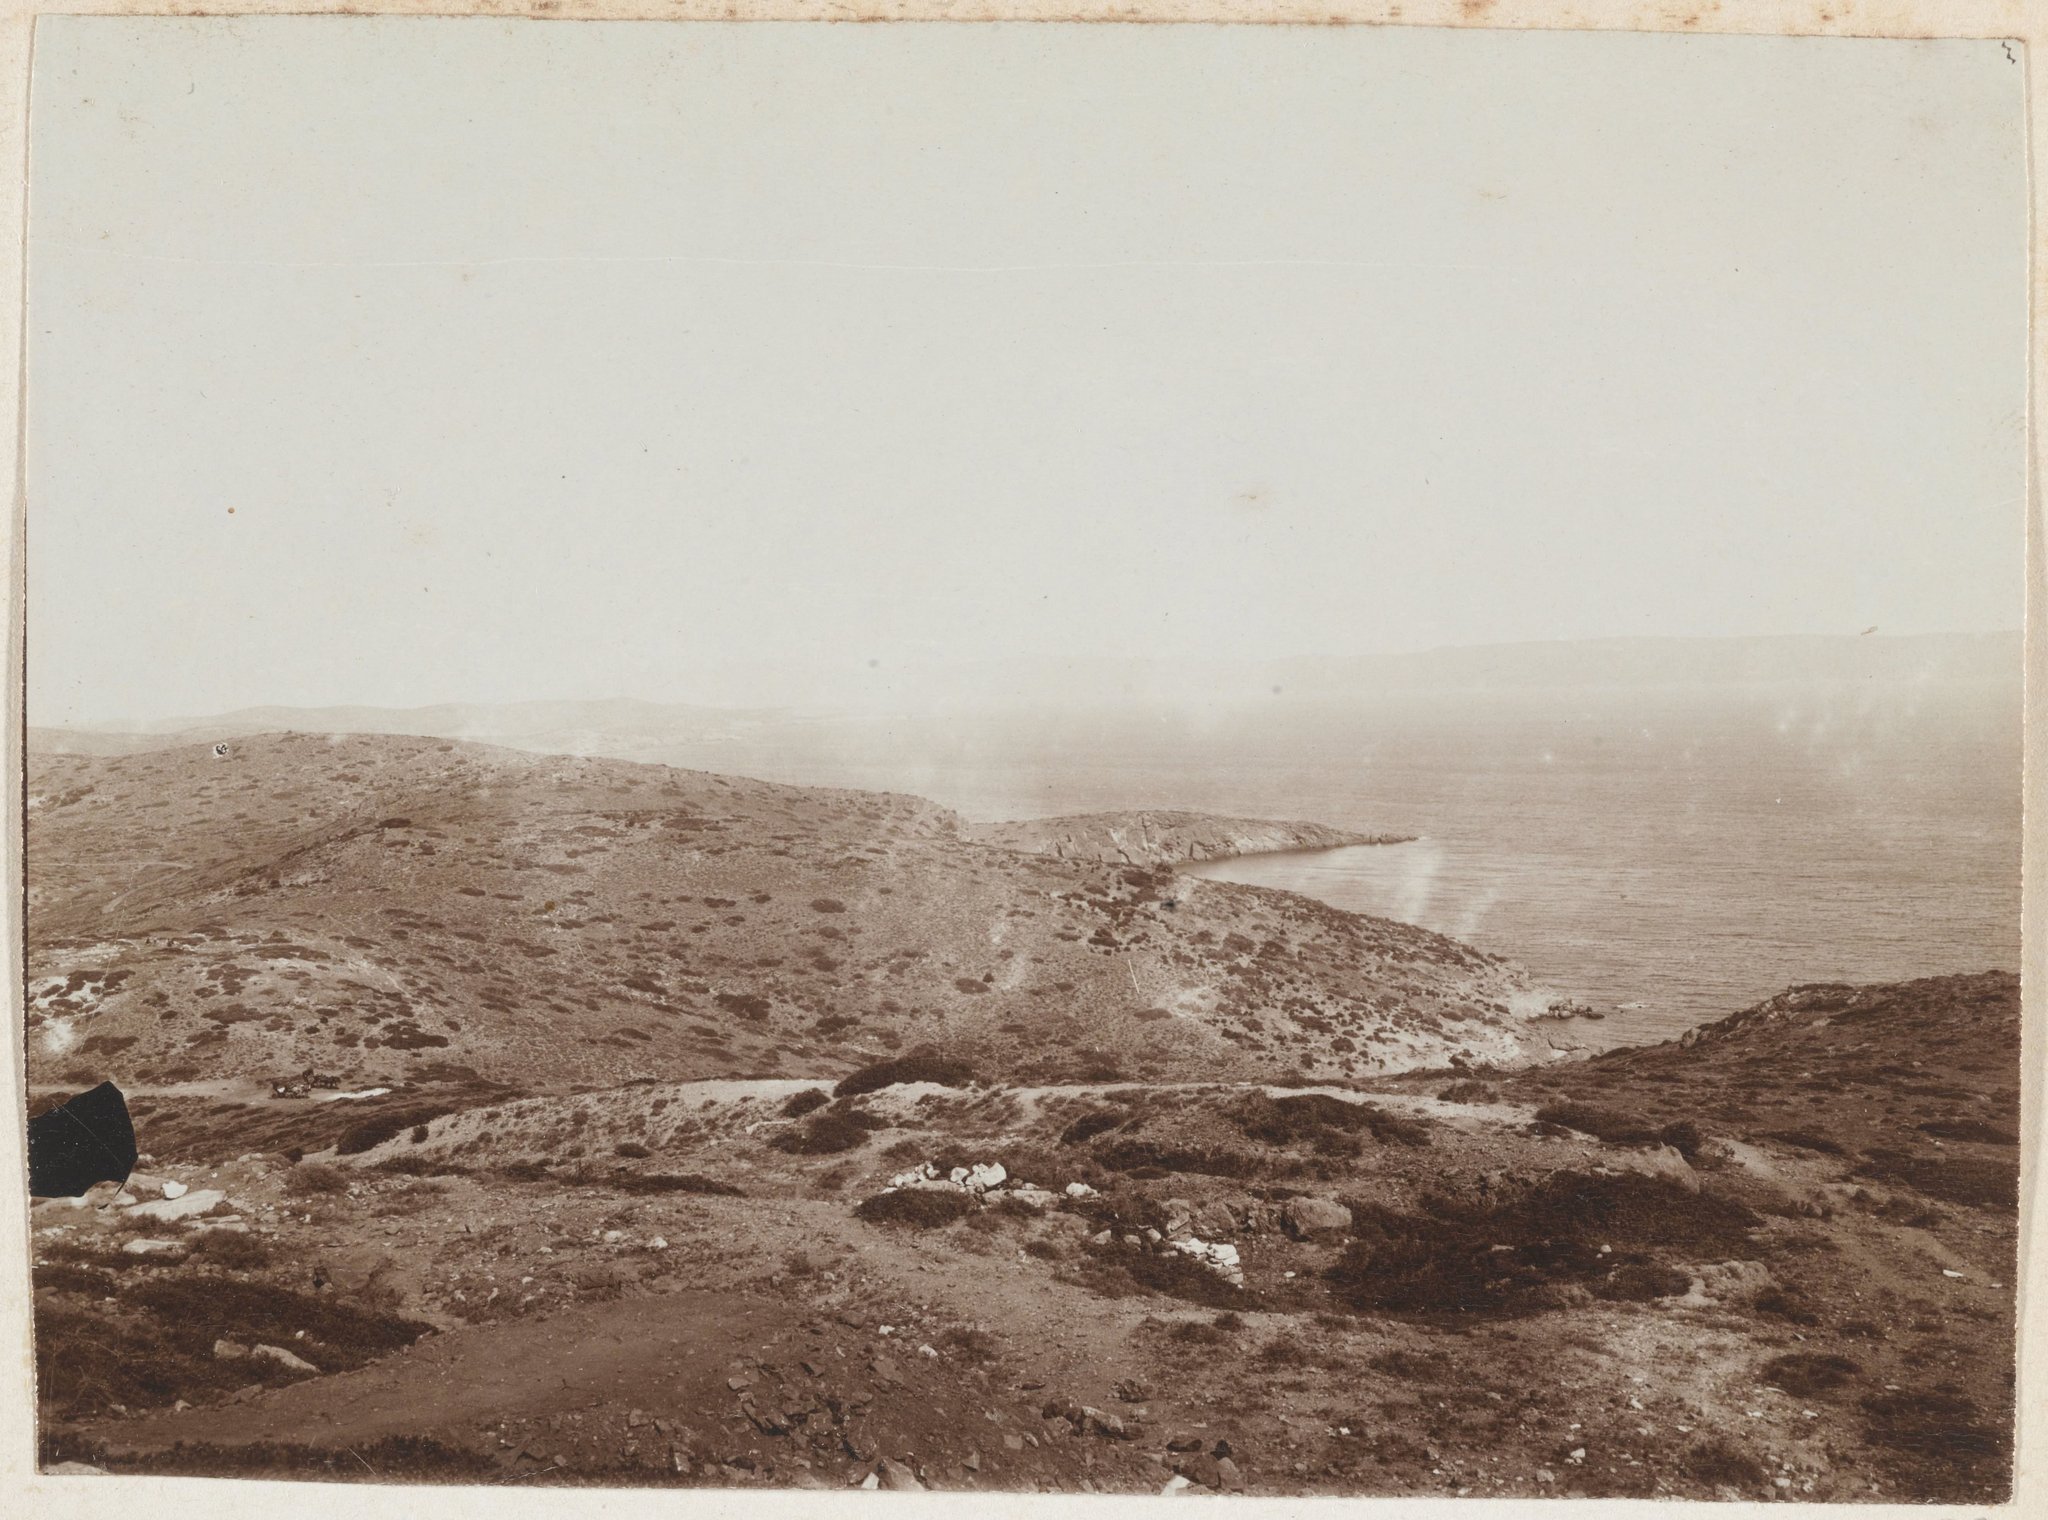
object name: page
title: Gezicht op een kaap in Griekenland, aangeduid als Kaap Kolonnäs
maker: johannes lodewijk heldring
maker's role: fotograaf, predikant, schrijver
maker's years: 1852-1923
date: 1898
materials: paper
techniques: collodion silver print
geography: greece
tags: cape (coast)